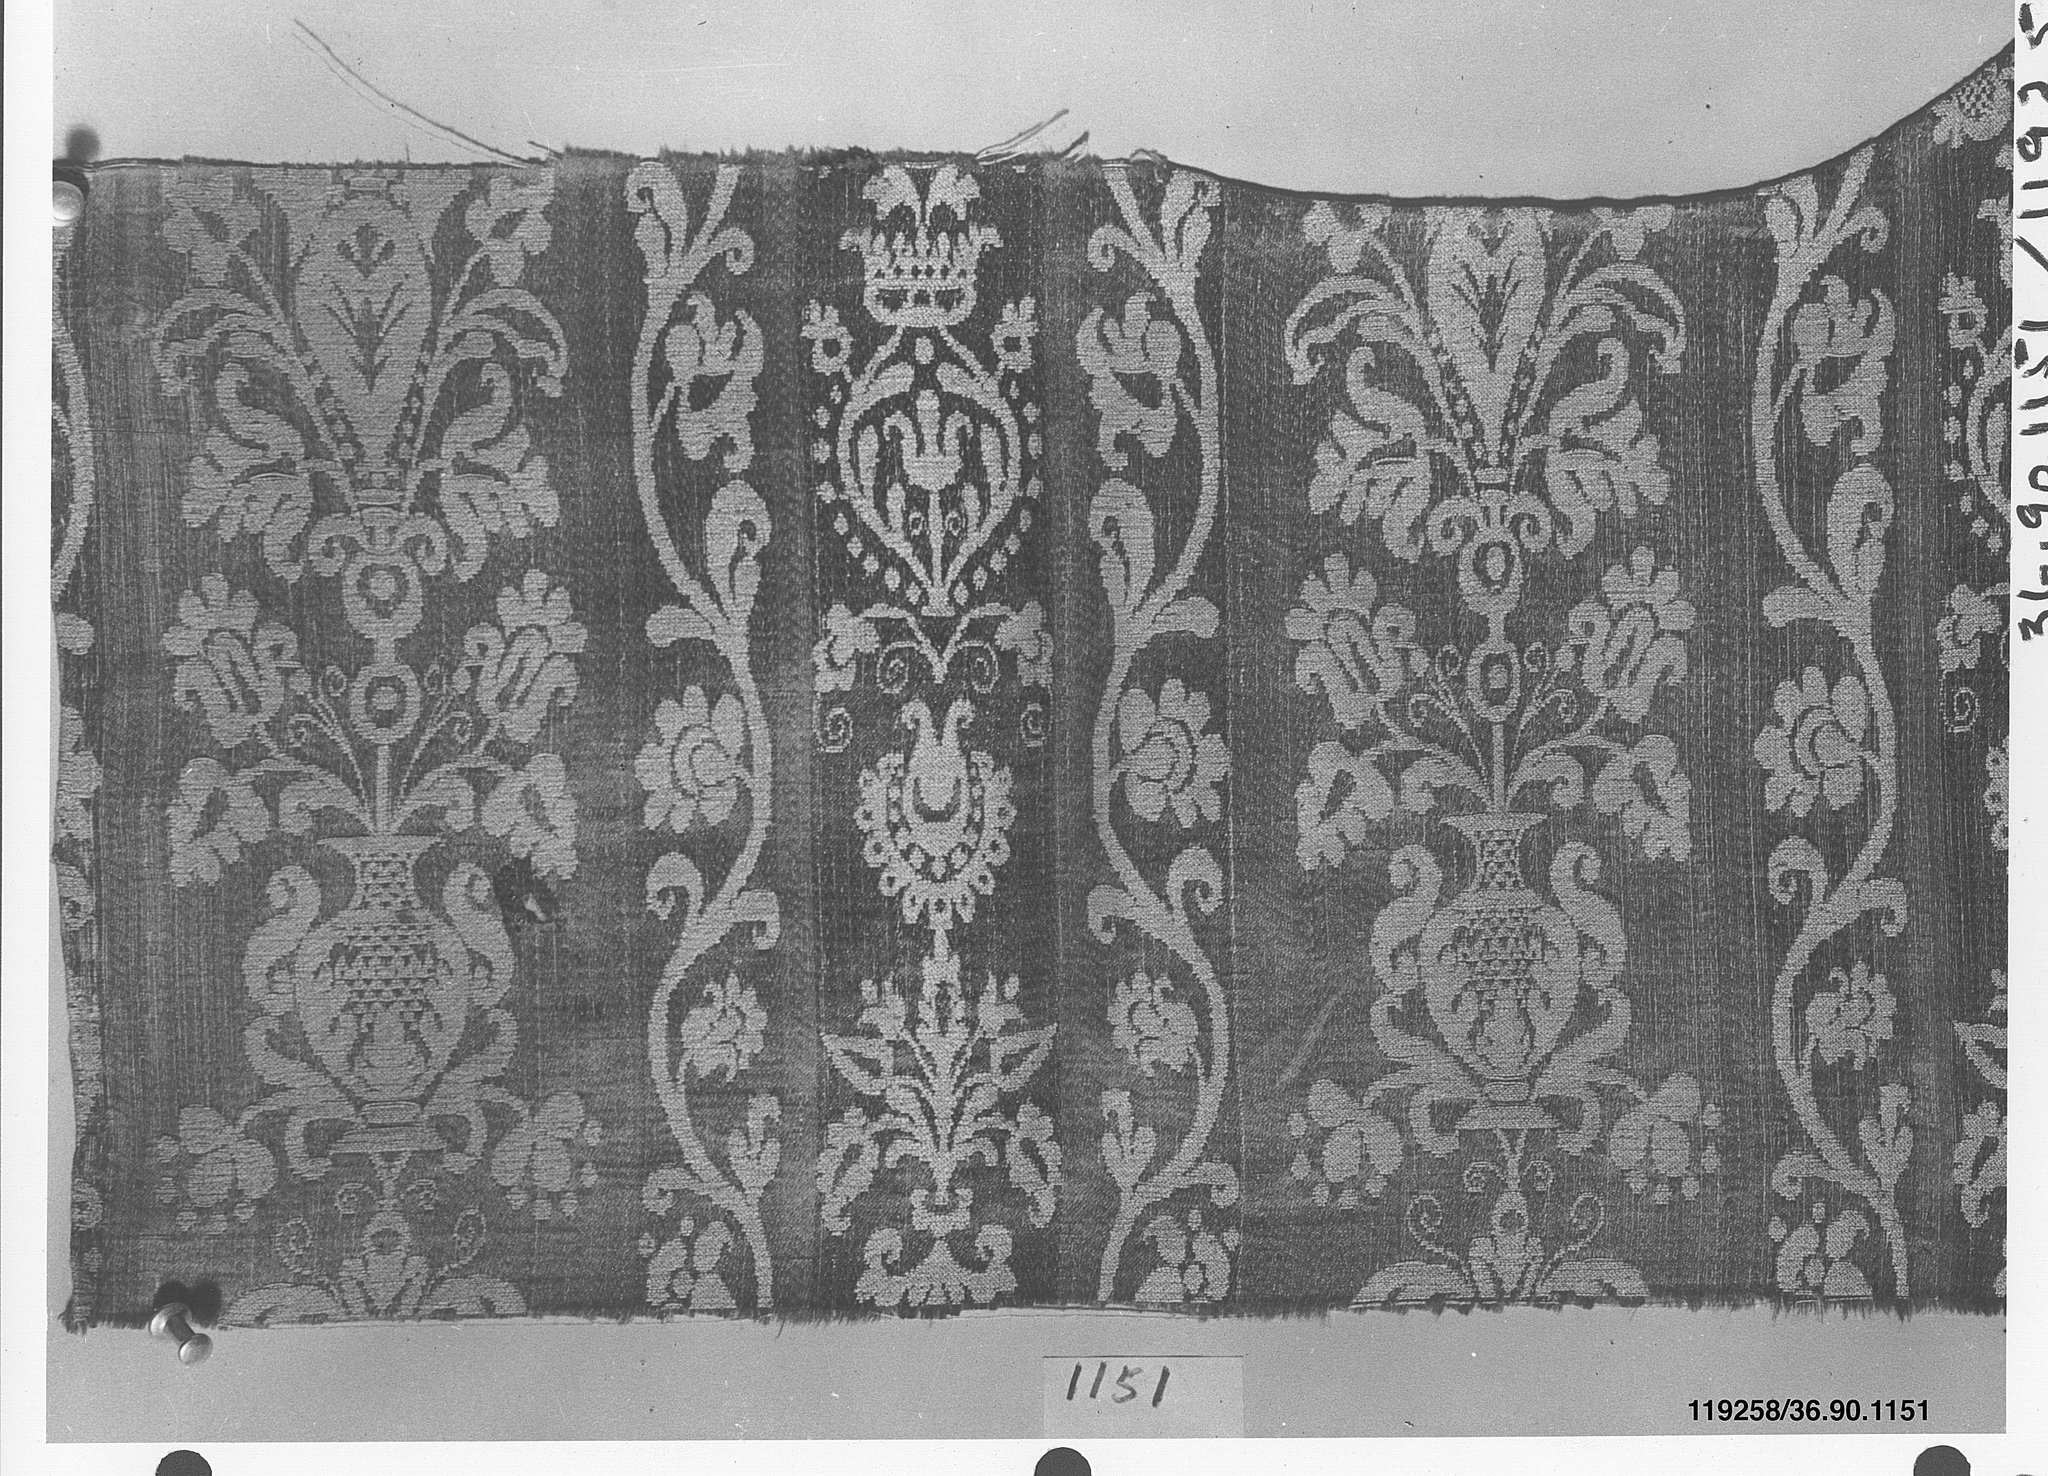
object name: piece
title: Woven silk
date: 1667-1700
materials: cotton, silk